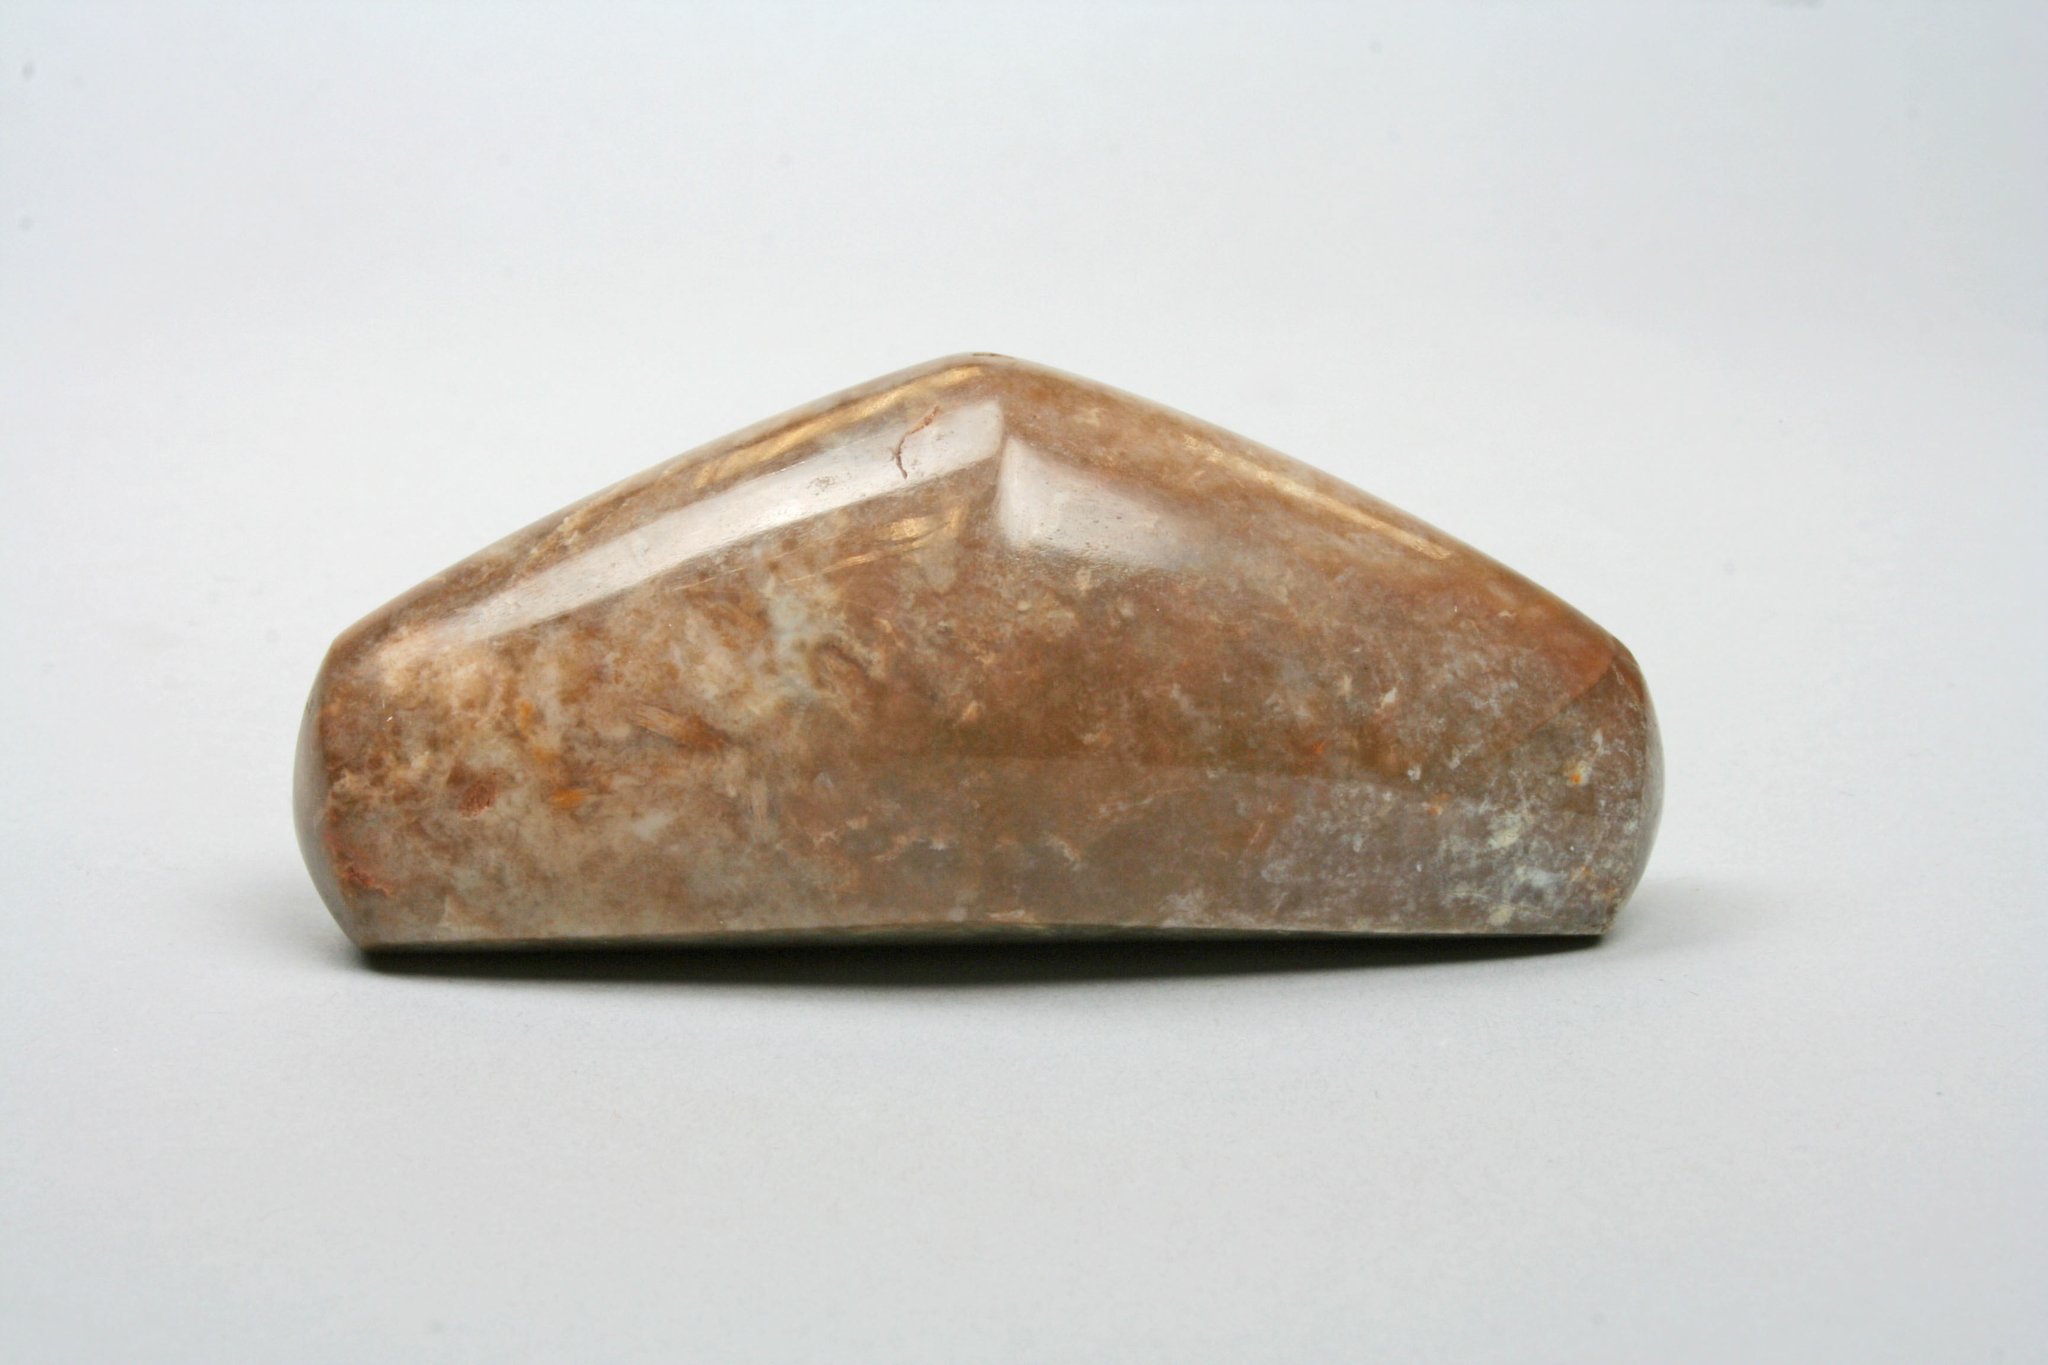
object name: ritual stone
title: Ritual Stone (pulidor)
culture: mexica, aztec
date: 1401-1533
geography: mexico